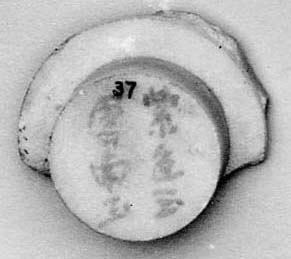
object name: fragment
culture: burmese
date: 1902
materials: jade